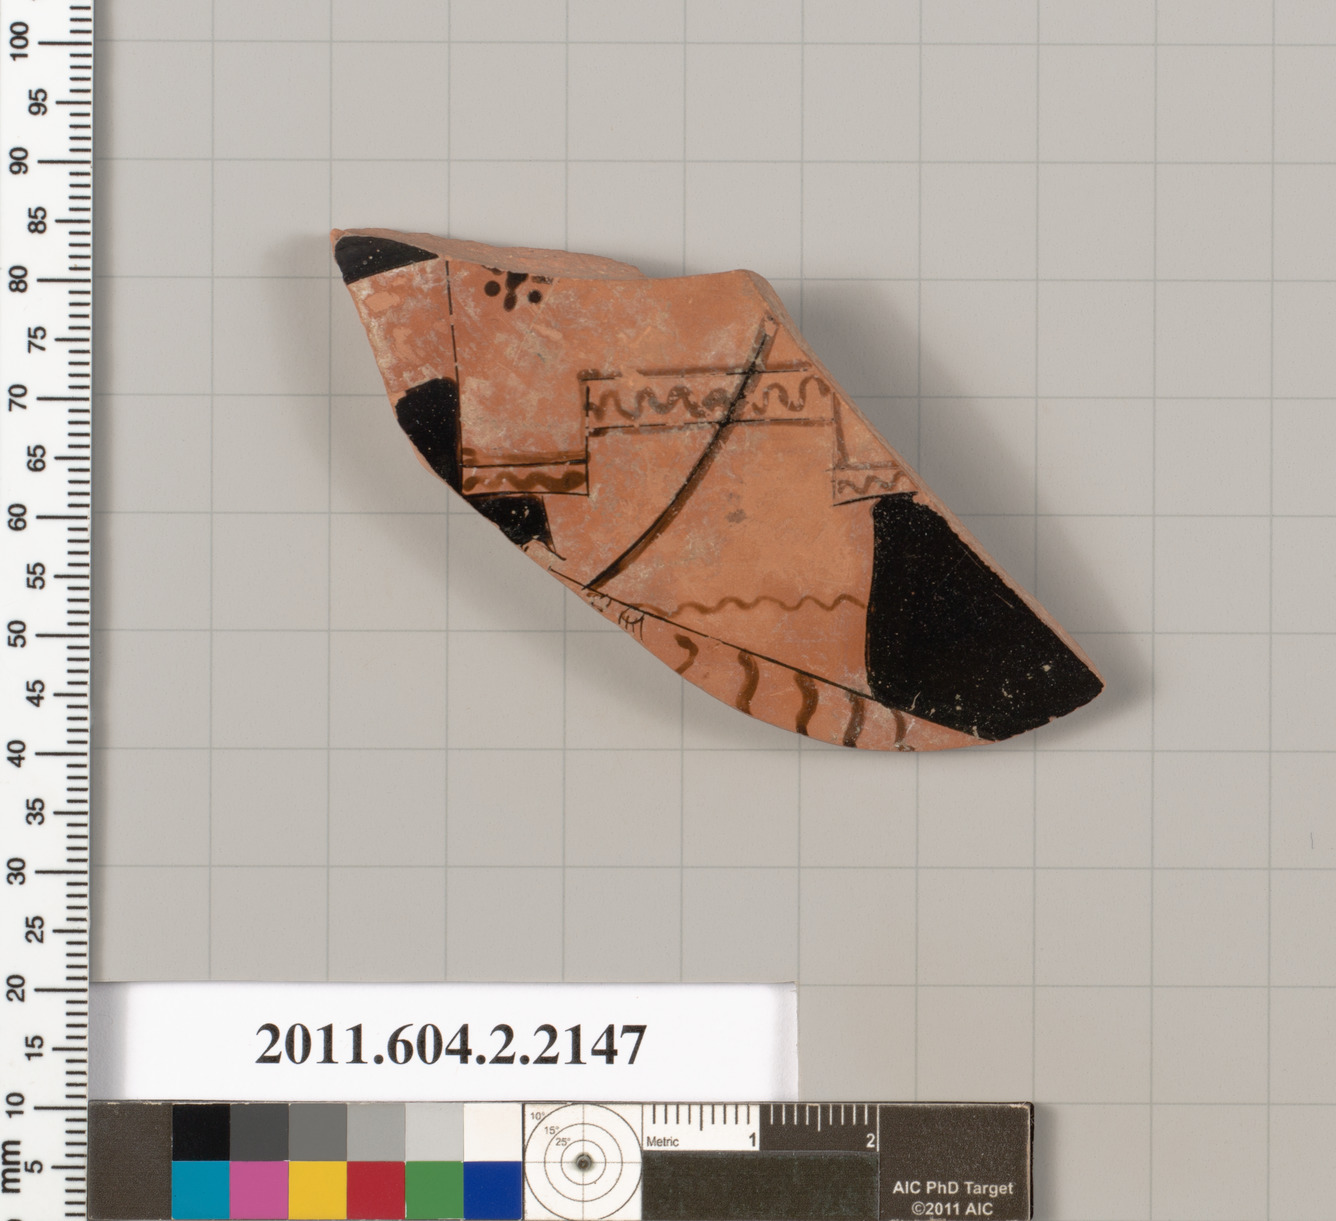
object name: pot fragment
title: Terracotta fragment of a pot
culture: greek, attic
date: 460-440 BCE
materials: terracotta